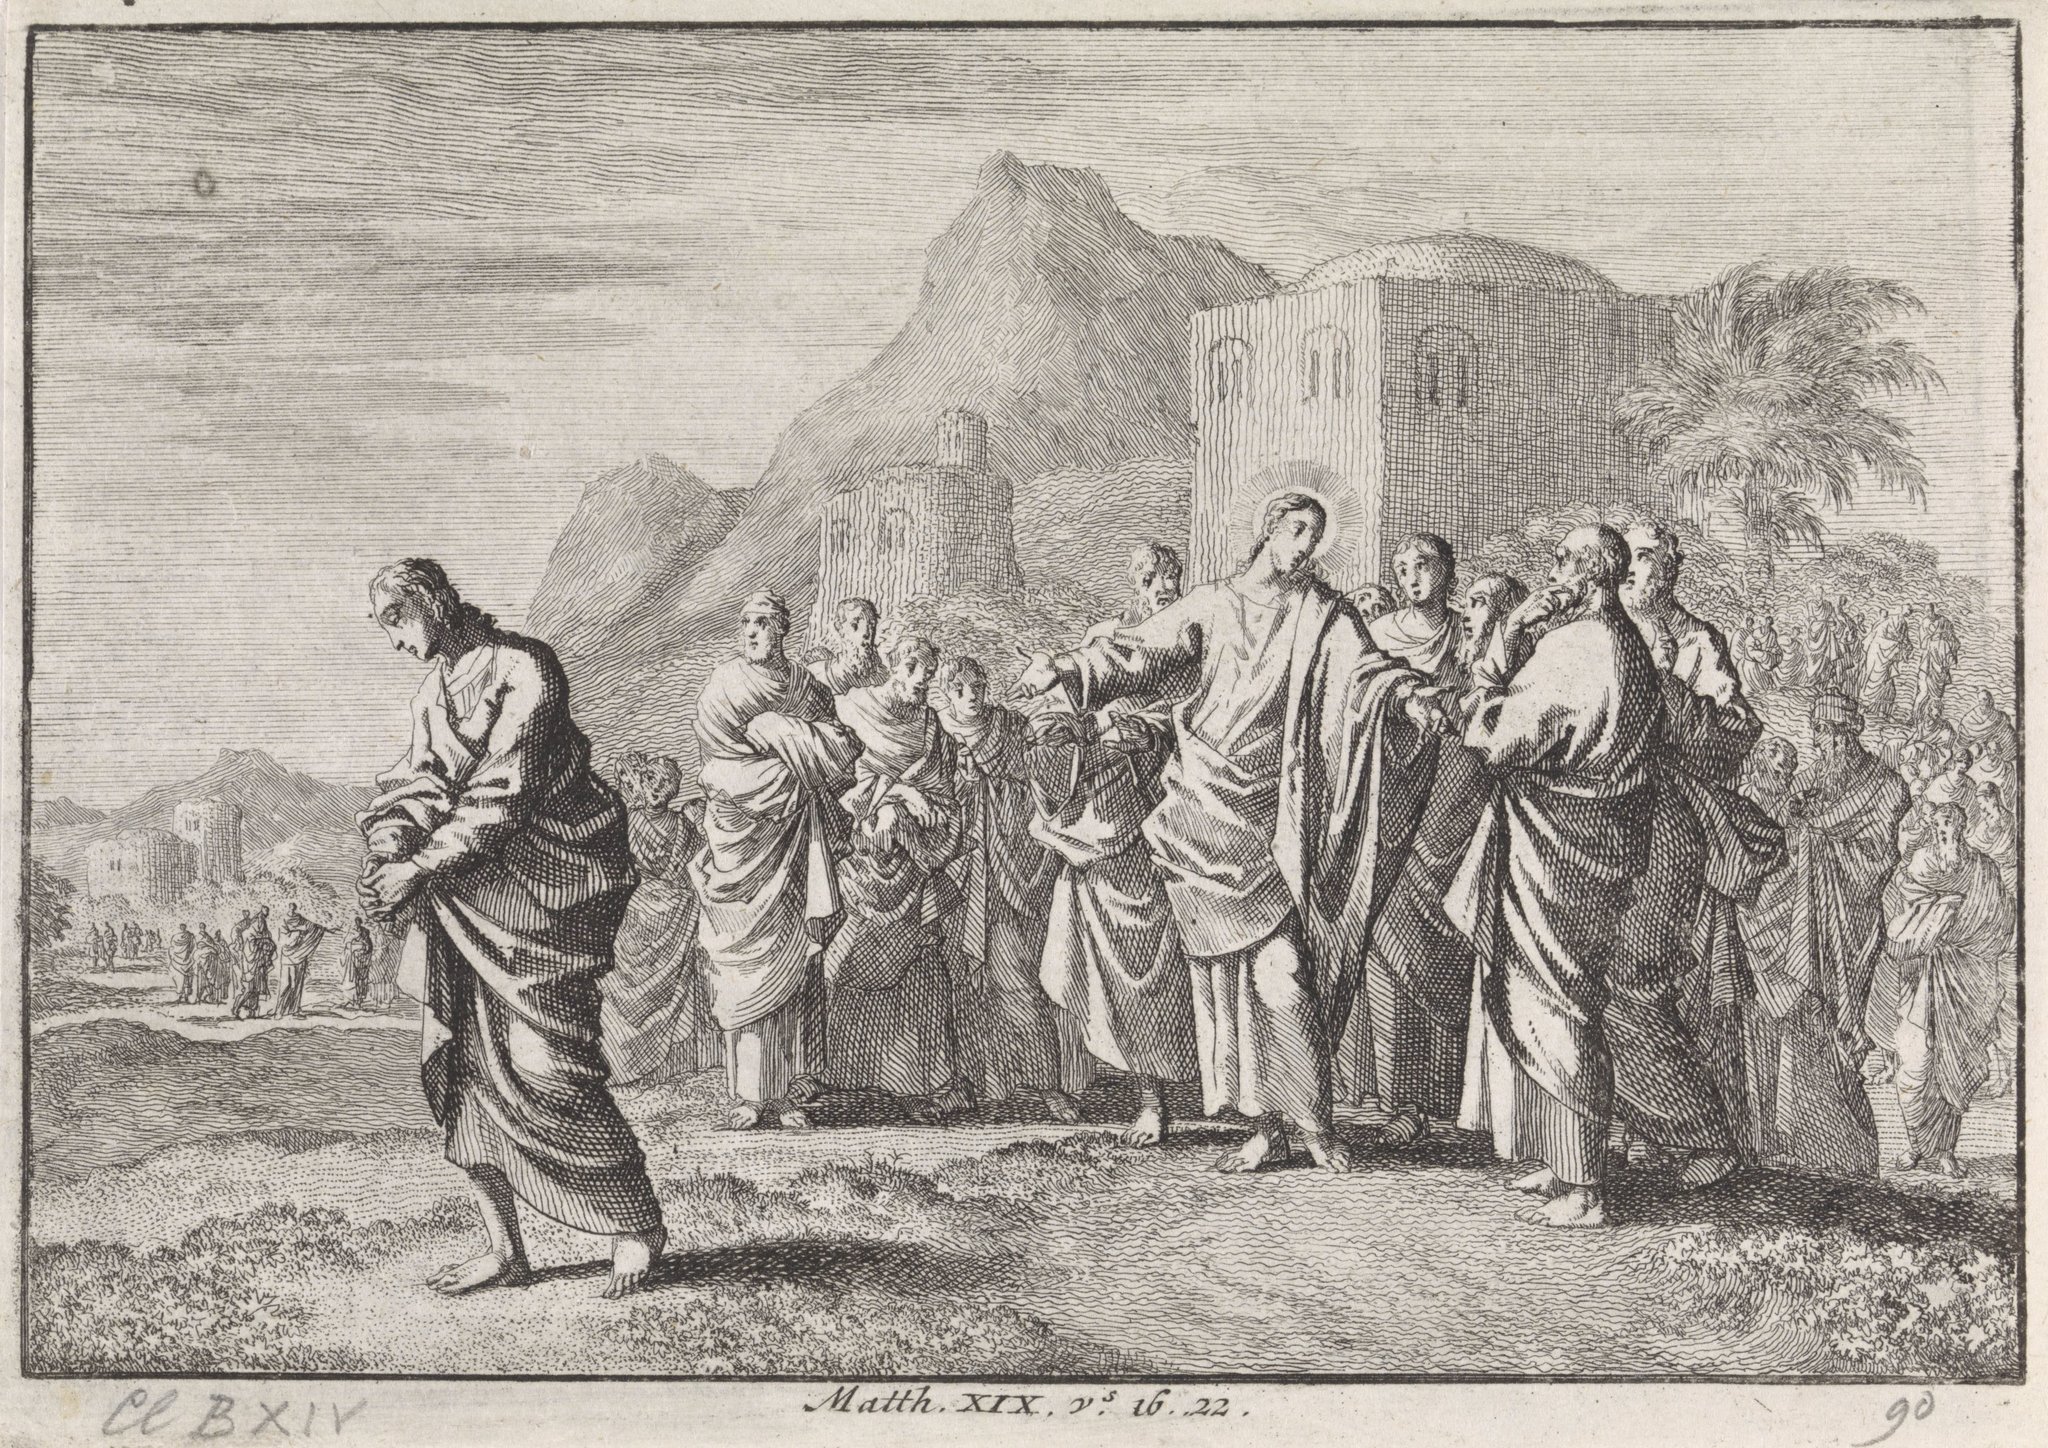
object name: print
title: Christus geeft raad aan een rijke jongeling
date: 1703-1762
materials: paper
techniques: etching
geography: amsterdam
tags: a rich young man who came to see christ goes away sorrowful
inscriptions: collector's mark: Lugt 2228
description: De prent komt een eerste keer voor als boekillustratie voor David Martin. Historie des Ouden en Nieuwen Testaments. Amsterdam, Pieter Mortier, 1703. Deel II. De boekillustraties voor de Mortierbijbel hebben verschillende staten en kopieën, waarbij de chronologische volgorde moeilijk te achterhalen valt. Als boekillustraties werden ze bovendien herhaaldelijk opnieuw gebruikt voor andere boekwerken.